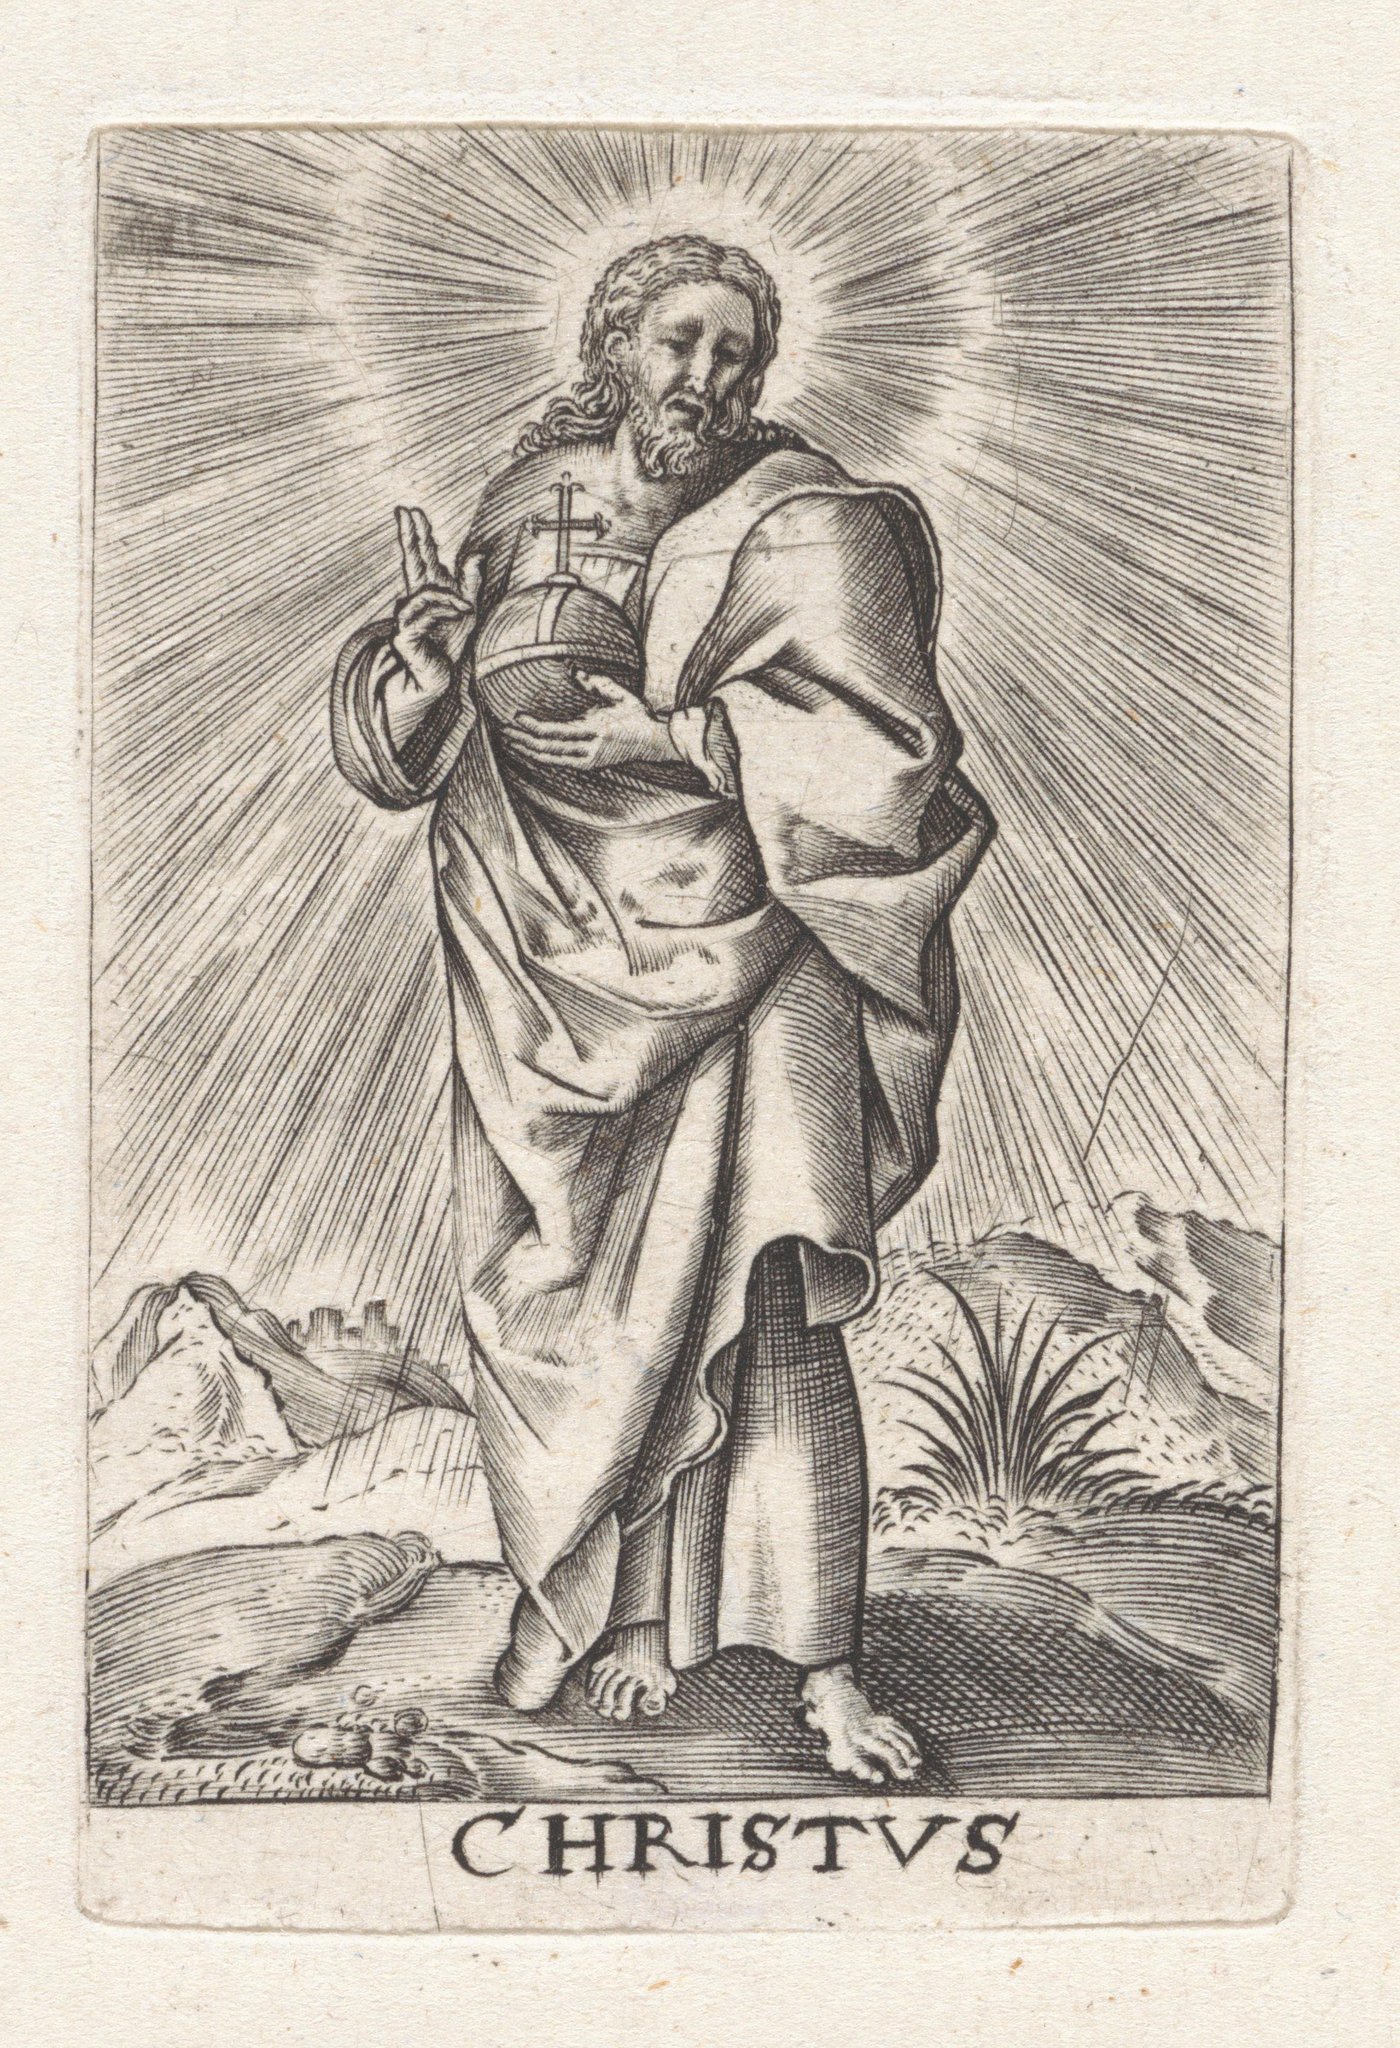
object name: print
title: Christus en de twaalf apostelen, en H. Paulus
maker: Anonymous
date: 1579-1629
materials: paper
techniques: engraving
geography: antwerp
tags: 'salvator mundi', making a blessing gesture; an orb in his hand or at his feet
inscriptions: collector's mark: Lugt 2227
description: Landschap met Christus. In zijn hand houdt hij een rijksappel, met zijn andere hand maakt hij een zegenend gebaar.